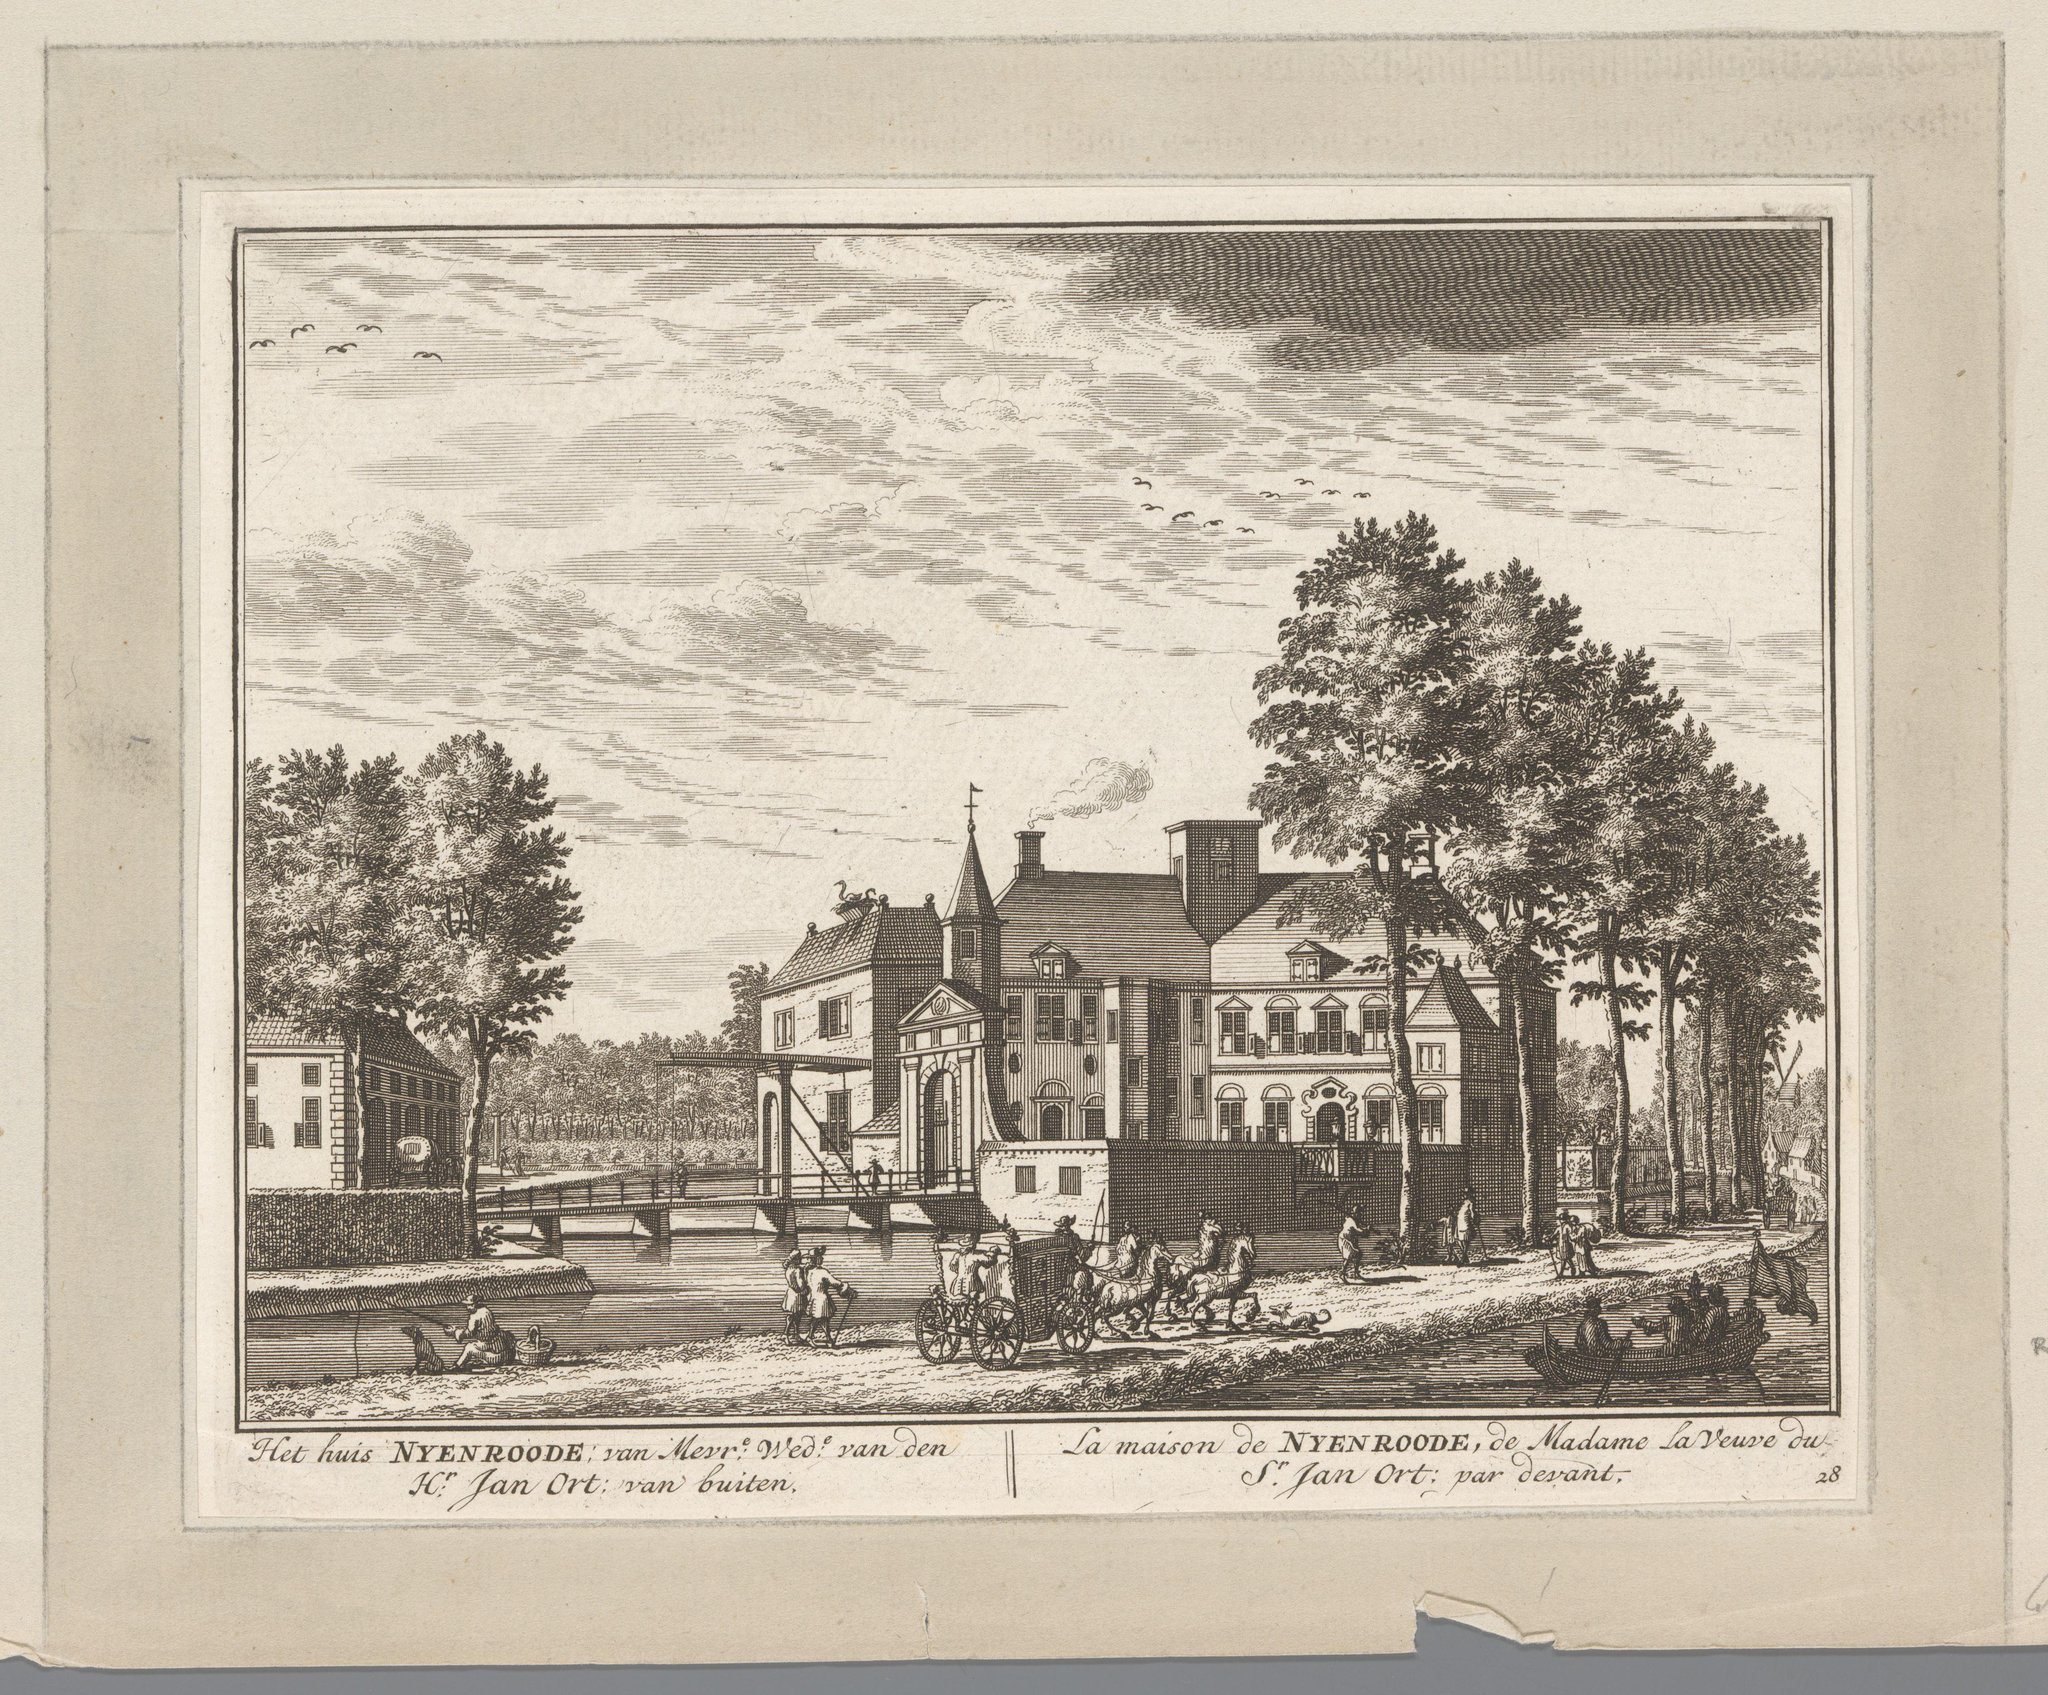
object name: print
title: Gezicht op kasteel Nijenrode bij Breukelen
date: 1719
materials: paper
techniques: etching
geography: amsterdam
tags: rural housing, e.g. country-house, villa, cottage, rowing-boat, canoe, etc., four-wheeled vehicle drawn by more than three animals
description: Prent uit: Stopendaal, Daniël. De zegepraalende Vecht, vertoonende verscheidenen gesichten van lustplaatsen, heeren huysen en dorpen, beginnende van Uitrecht en met Muyden besluytende. Amsterdam: Weduwe Nicolaas Visscher, 1719.